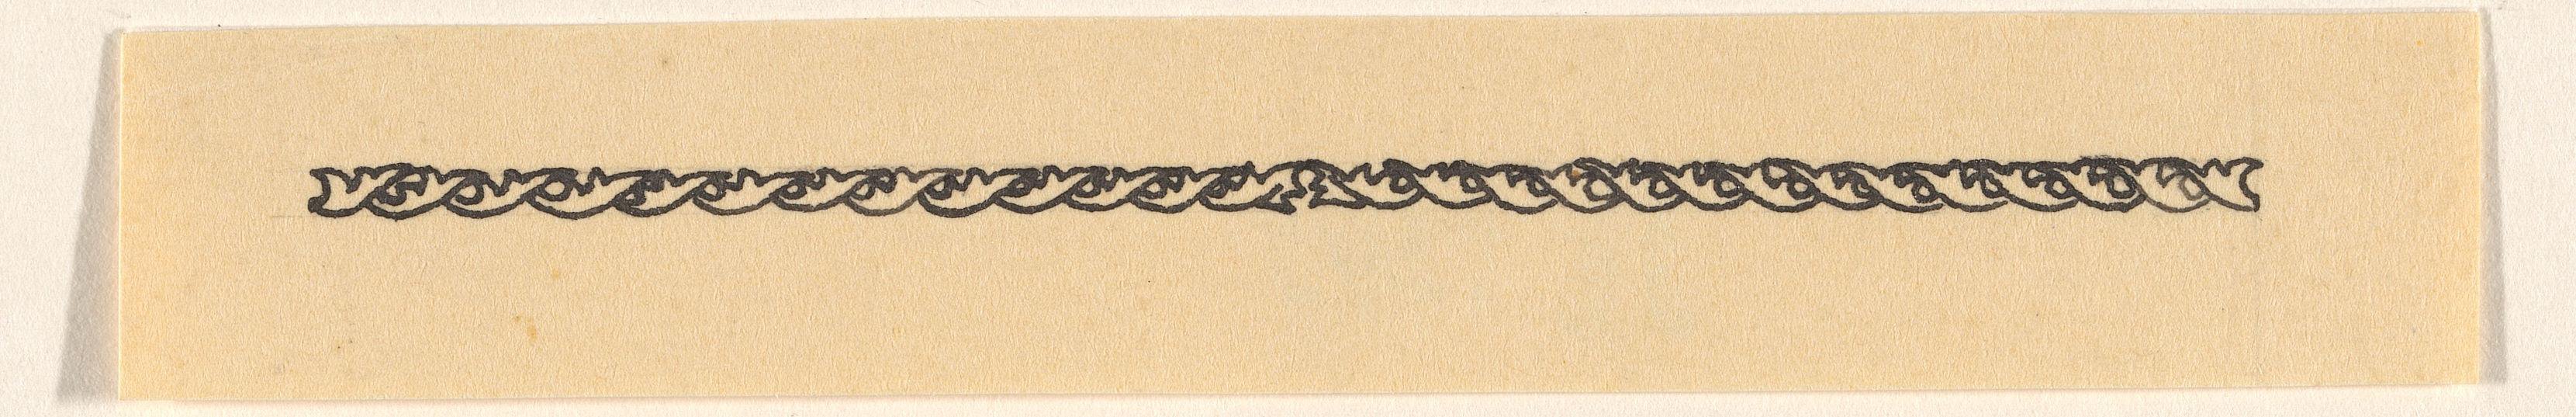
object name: drawing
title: Vignette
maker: julie de graag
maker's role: draughtsman, print maker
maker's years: 1877-1924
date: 1888-1924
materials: ink, paper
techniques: pen